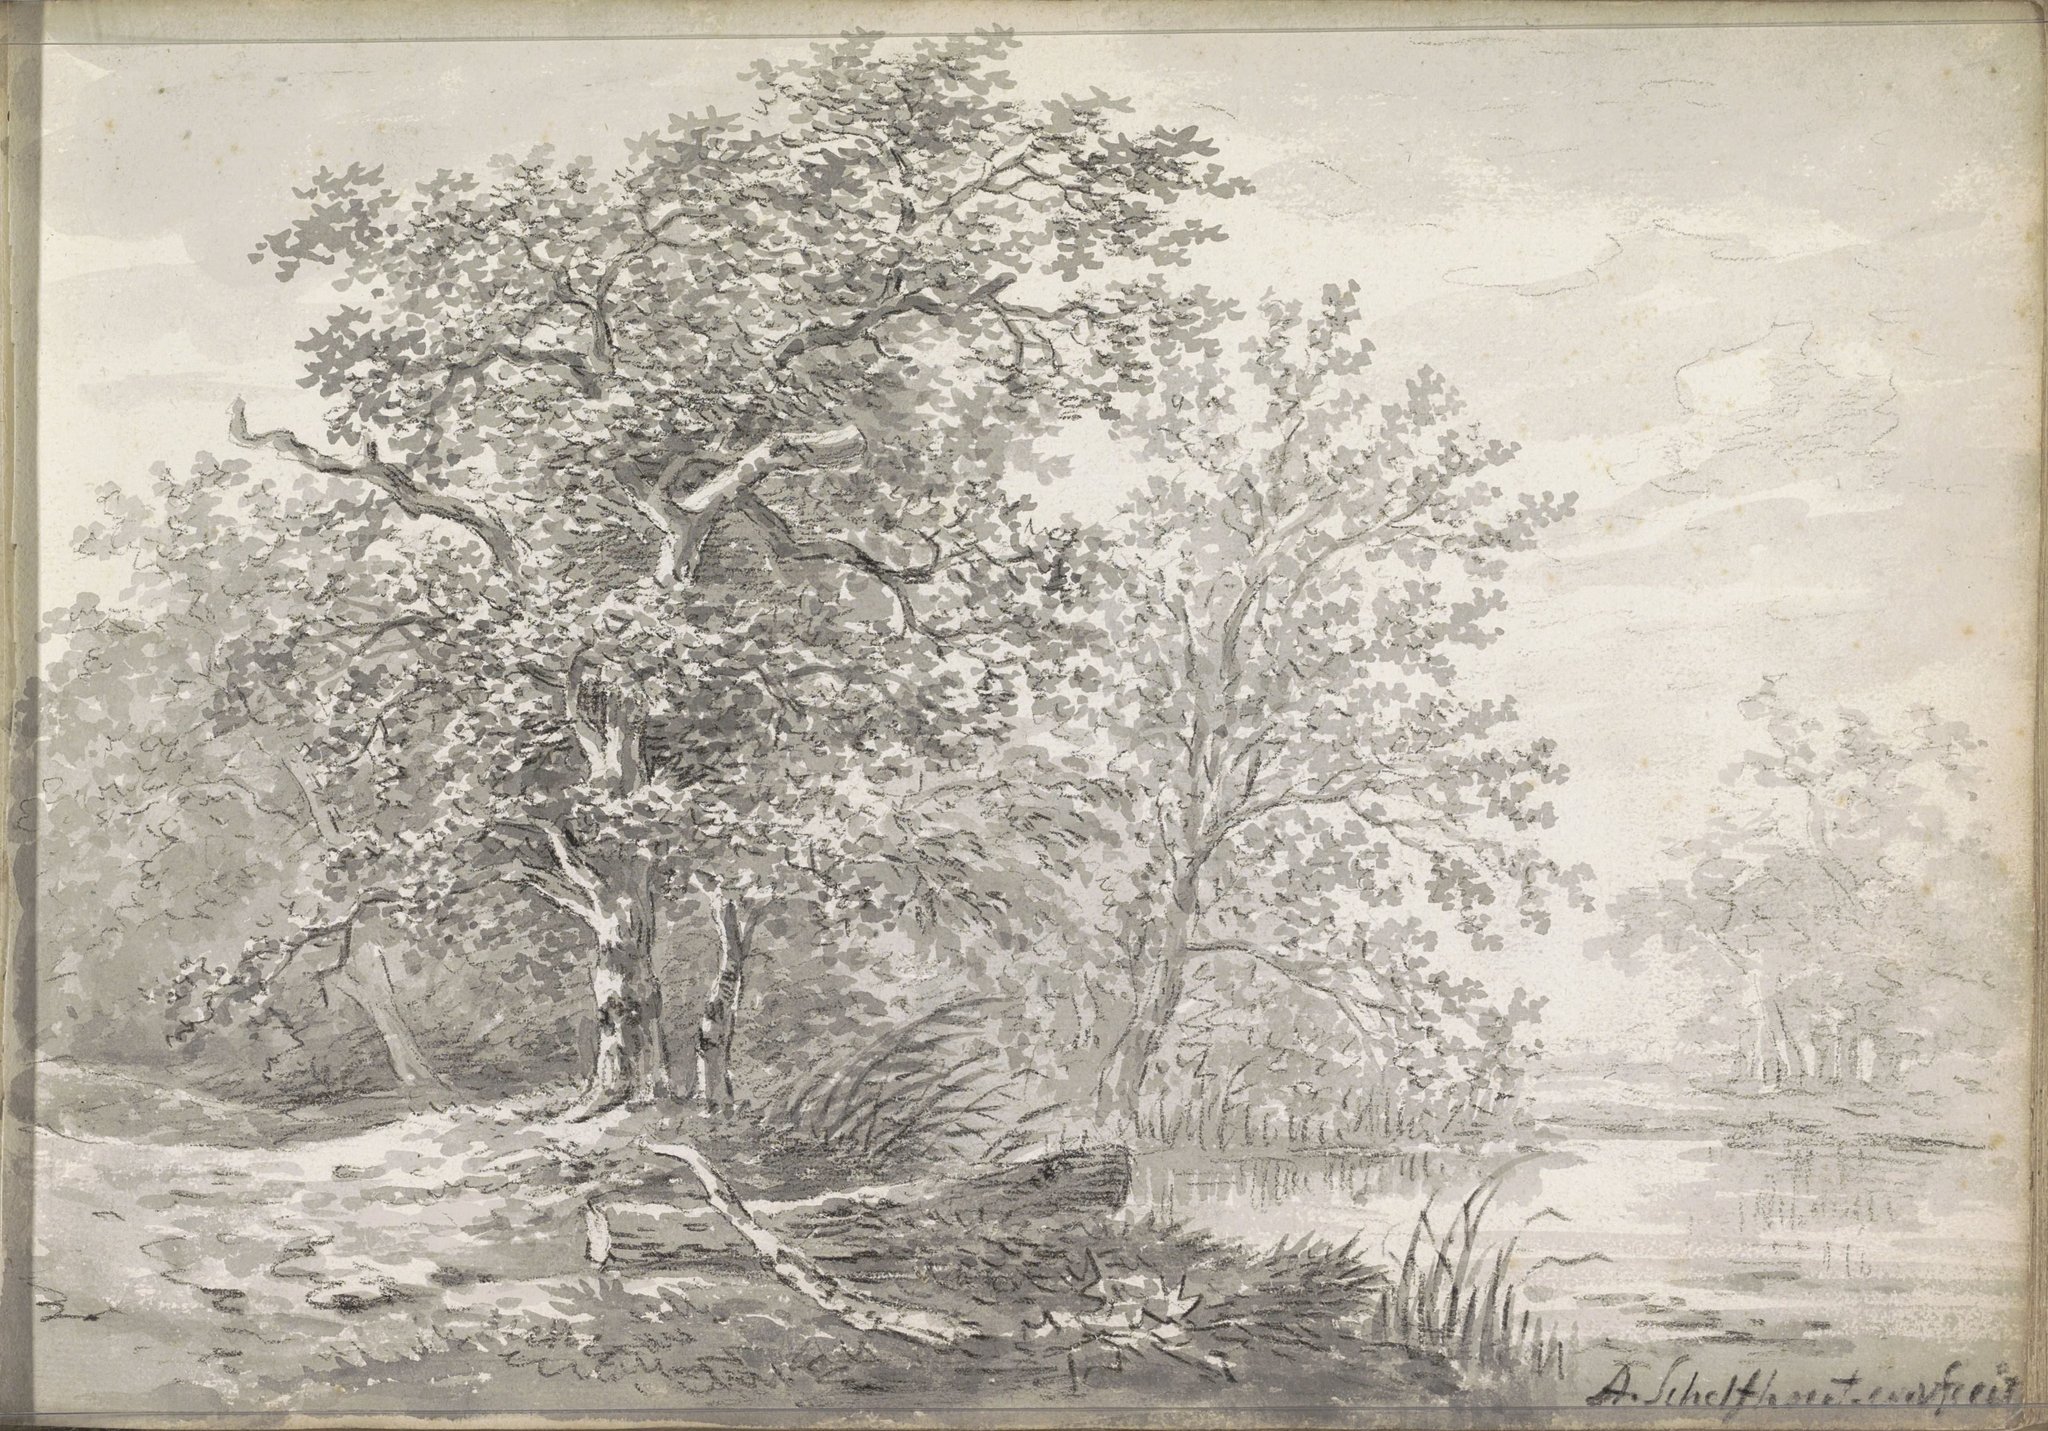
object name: sketchbook leaf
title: Bomen aan een waterkant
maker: andreas schelfhout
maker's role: draughtsman, painter, print maker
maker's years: 1787-1870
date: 1811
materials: chalk, paper, watercolor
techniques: brush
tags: trees, landscapes with waters, waterscapes, seascapes (in the temperate zone)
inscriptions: signature: ‘A. Schelfhout.[...]fecit’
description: Blad 2 recto uit een schetsboek met 75 bladen.